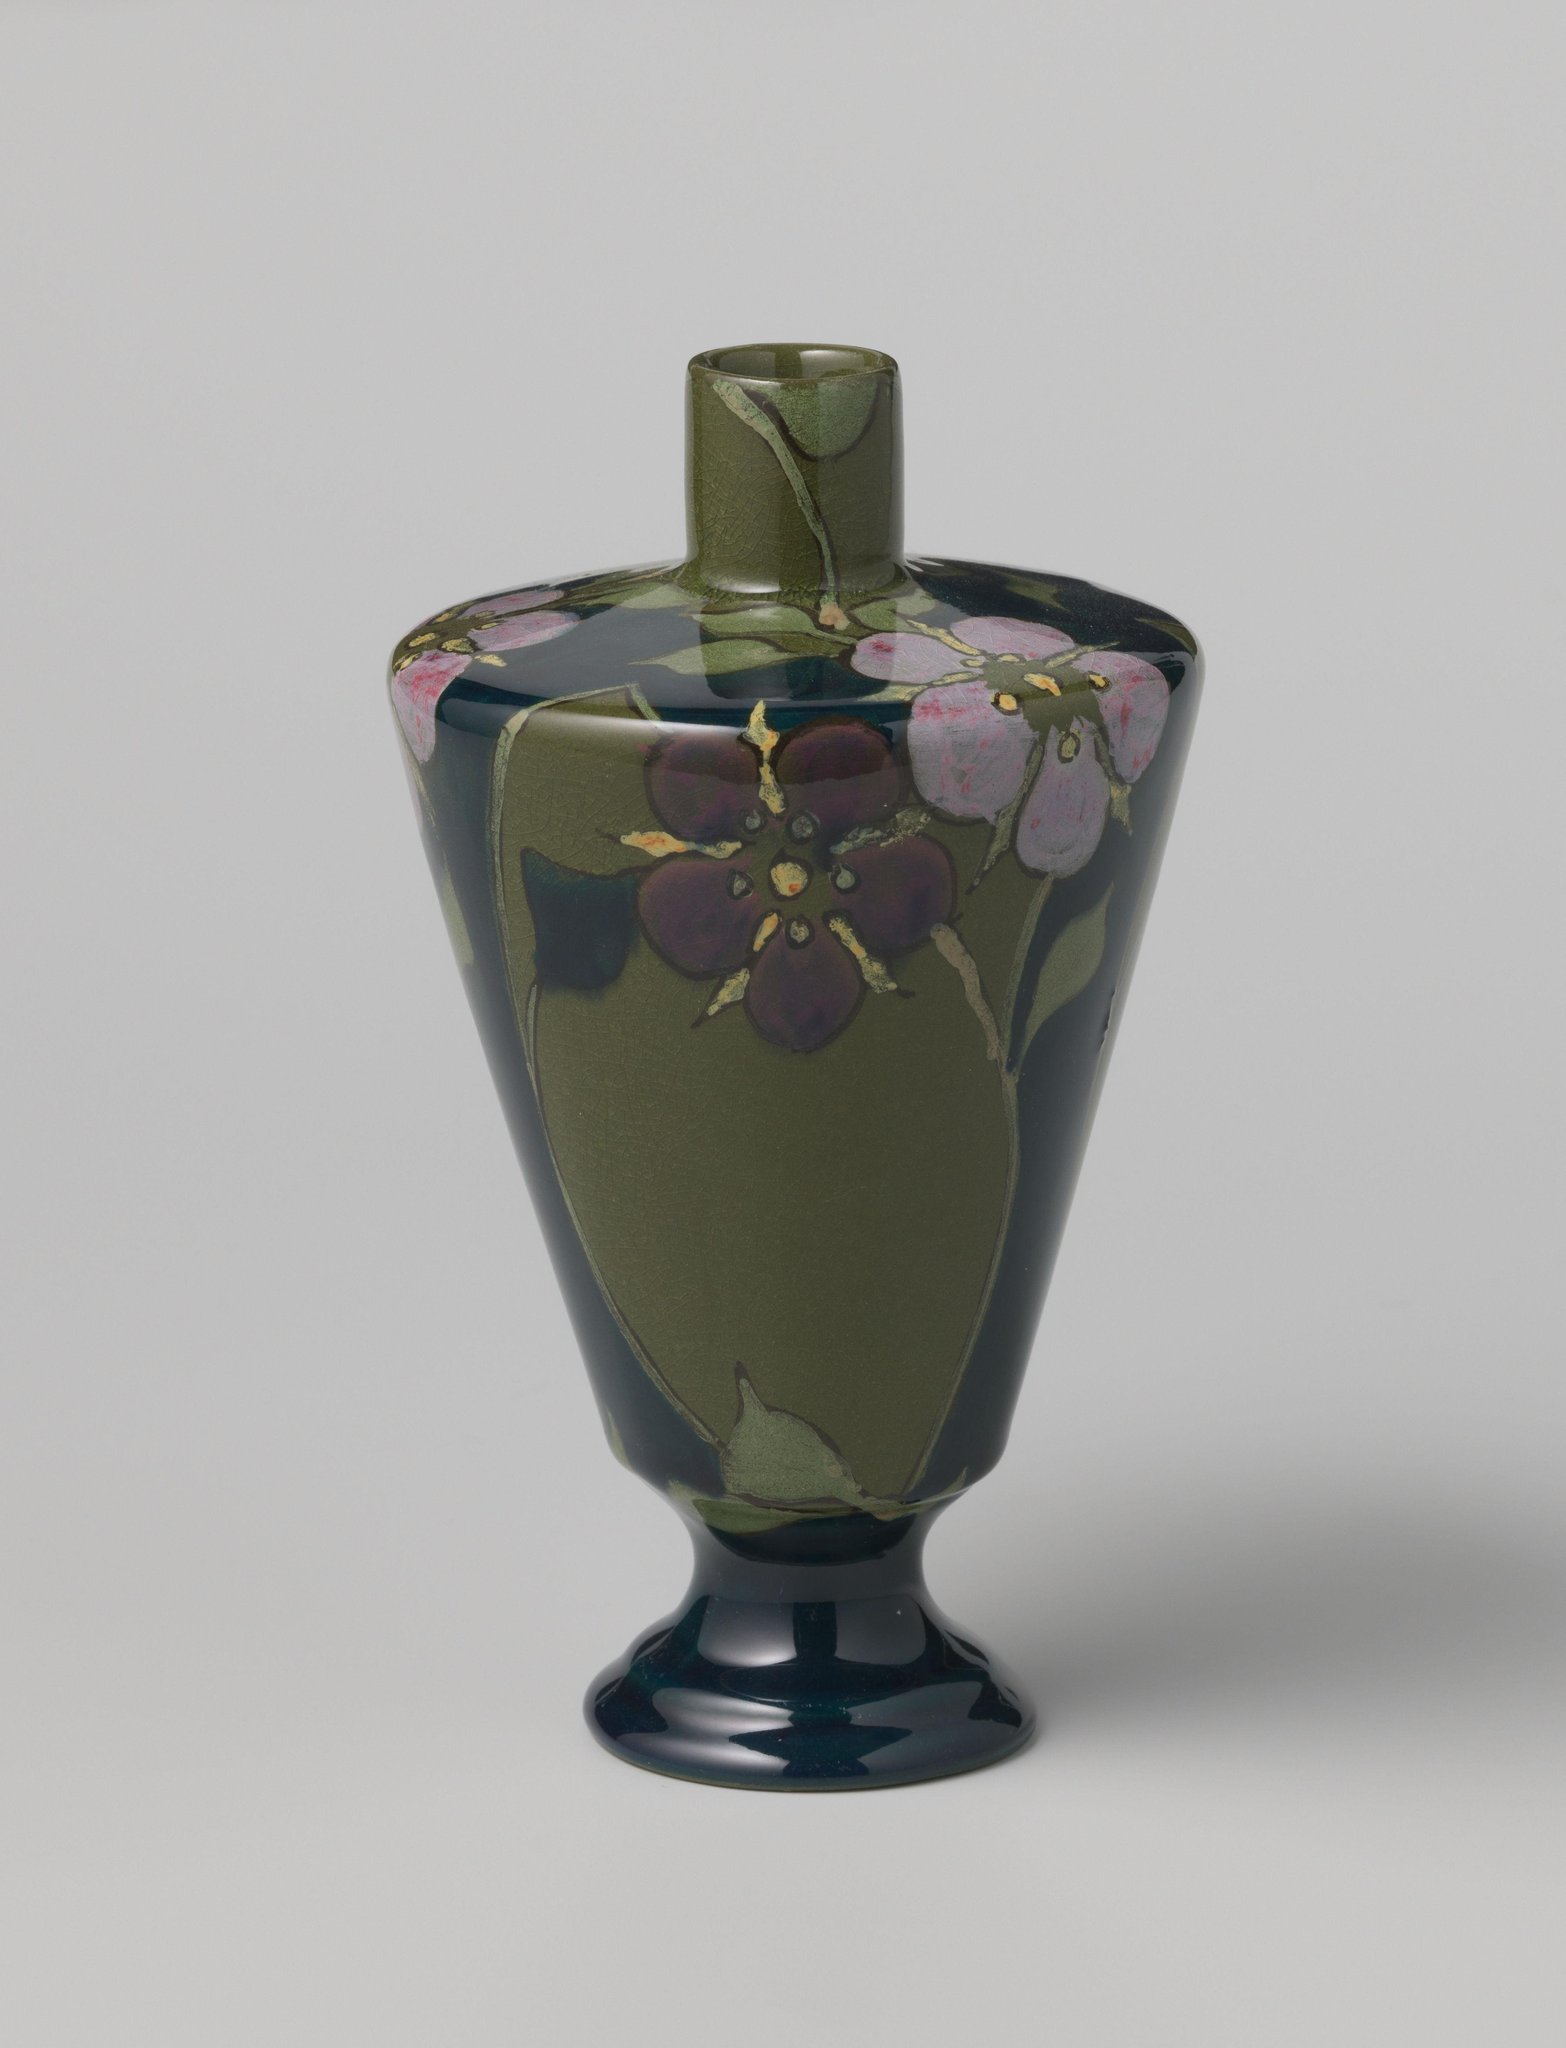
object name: vase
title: Vaas met polychrome decoratie van paarse en rose bloemen aan een stengel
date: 1915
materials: earthenware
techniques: vitrification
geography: gouda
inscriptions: mark: ‘fabrieksmerk // Zuid-Holland (in zwart) ; 48 (ingegrift)’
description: Vaas van aardewerk, op ronde voet, met trechtervormig lichaam met vlakke schouder en kleine cilindervormige hals. Polychroom beschilderd in groen, geel, roze en paars met drie maal een paarse en een roze bloem aan een stengel tegen een deels groene, deels donkerblauwe fond.